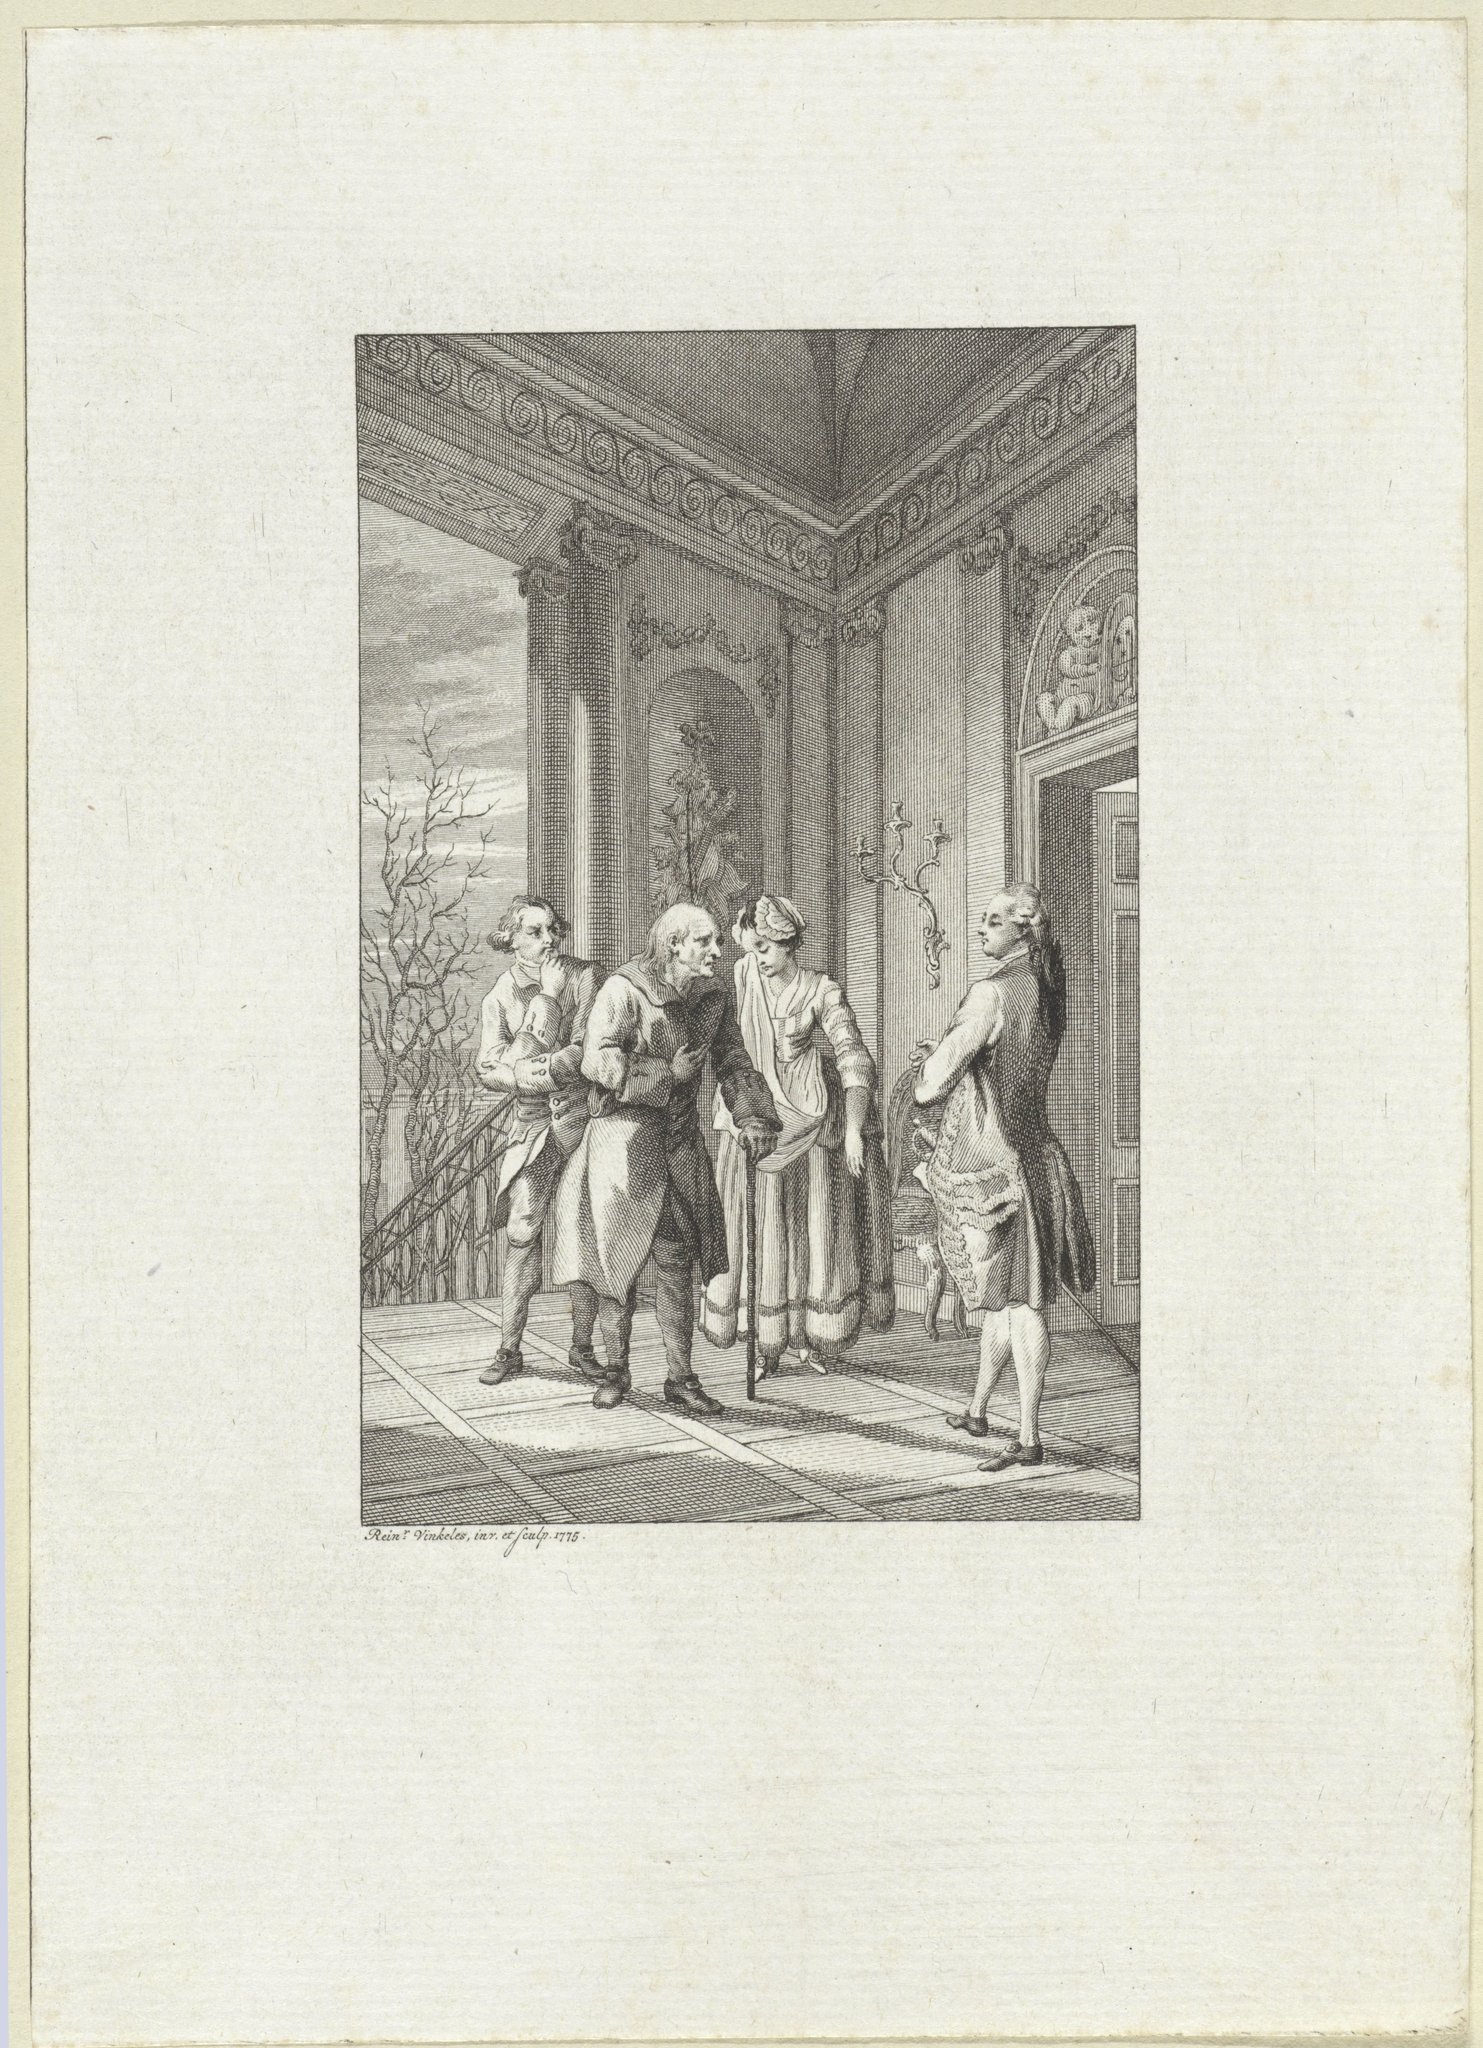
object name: print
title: Arme oude man in gesprek met een rijke heer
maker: reinier vinkeles (i)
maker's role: draughtsman, print maker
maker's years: 1741-1816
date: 1775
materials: paper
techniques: engraving, etching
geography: amsterdam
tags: walking-stick, staff, contrast between rich and poor, conversation, dialogue; conversation piece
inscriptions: collector's mark: Lugt 240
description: Proefdruk van illustratie voor: Mercier, Louis-Sébastien. De behoeftige. Amsterdam: Pieter Meyer, 1775.